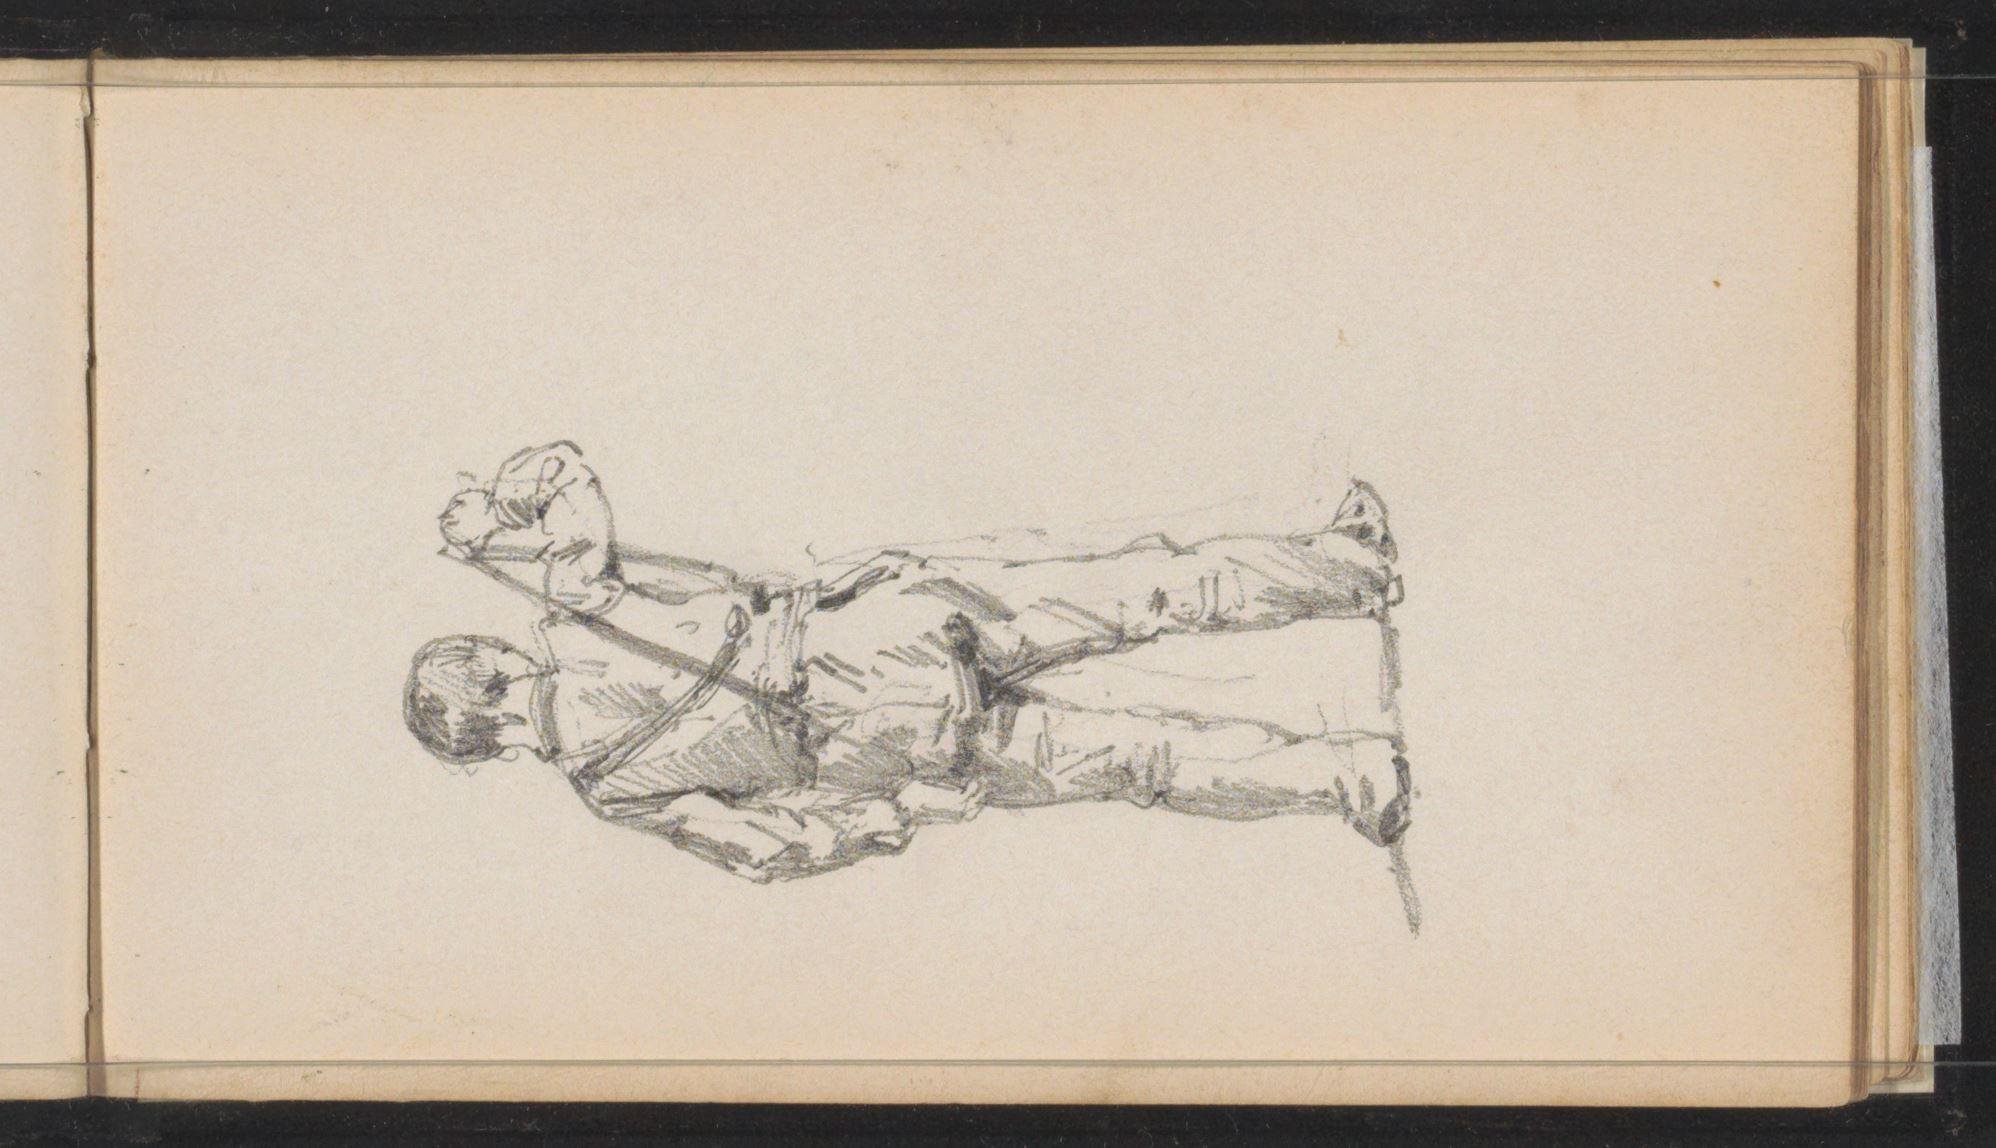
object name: sketchbook leaf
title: Man met een voorwerp in zijn handen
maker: cornelis springer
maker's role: draughtsman, painter, print maker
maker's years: 1817-1891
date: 1860-1866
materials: paper, pencil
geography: netherlands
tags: adult man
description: Man met een voorwerp in zijn handen, op de rug gezien. Blad 28 uit een schetsboek met 44 bladen.